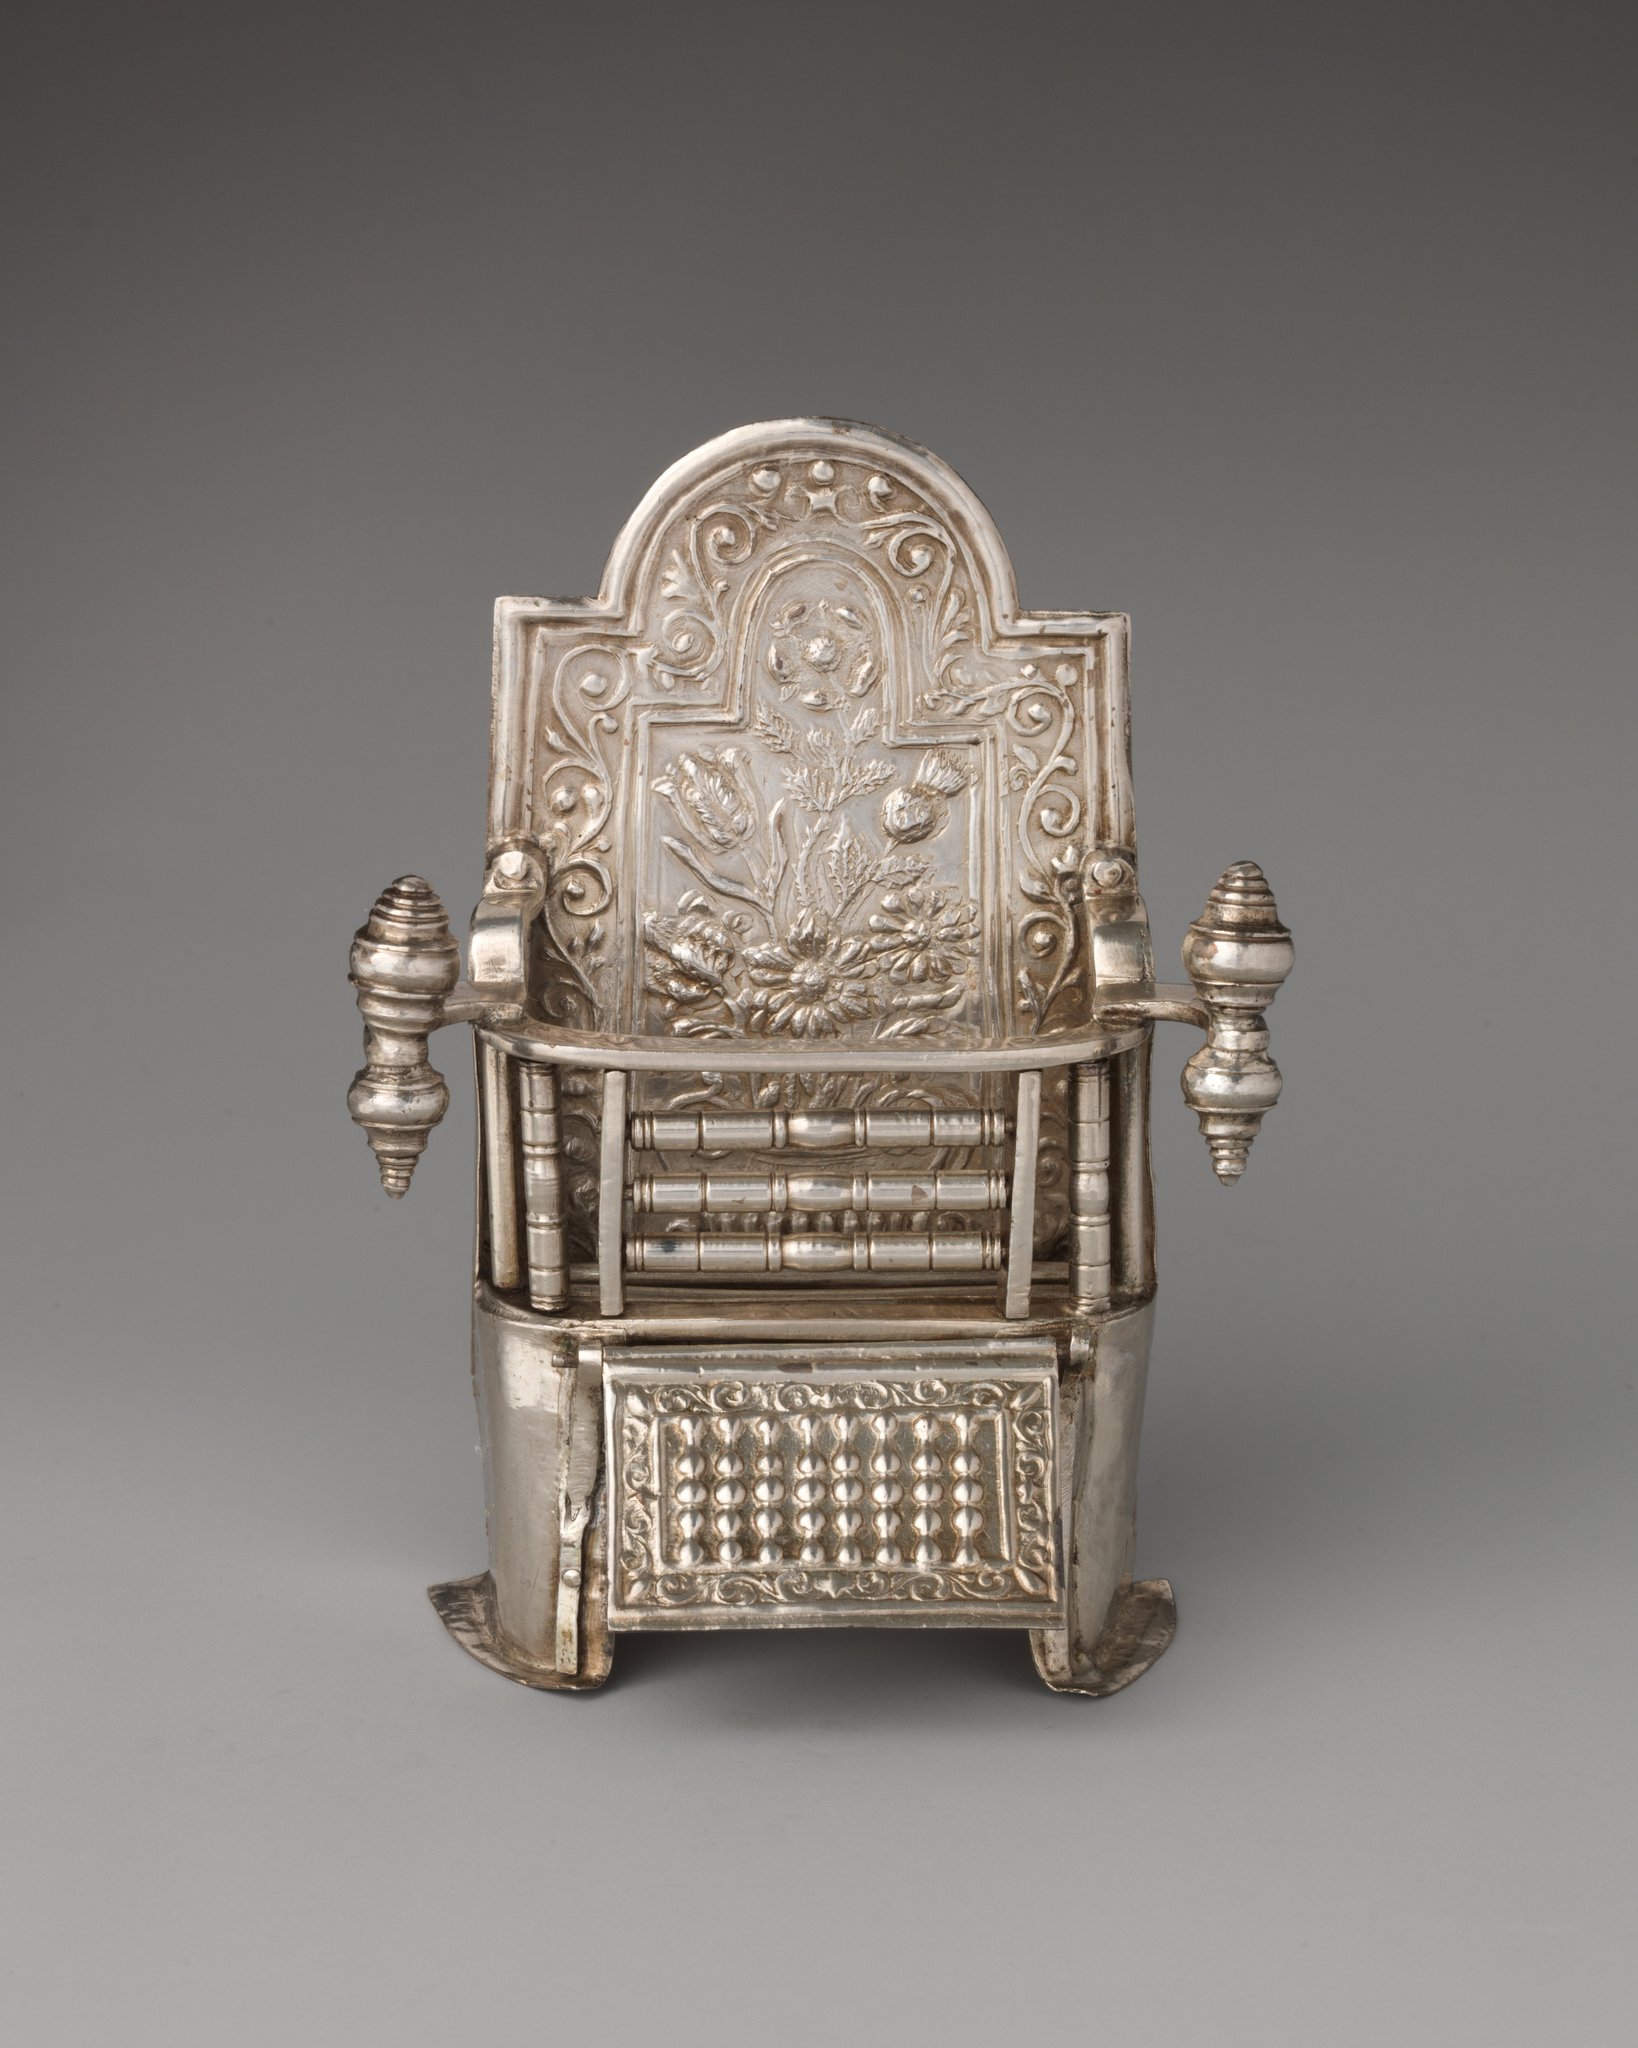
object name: fireback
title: Miniature fireback (part of a set)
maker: david clayton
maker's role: maker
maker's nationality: british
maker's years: 1659-1719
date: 1667-1733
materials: silver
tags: flowers